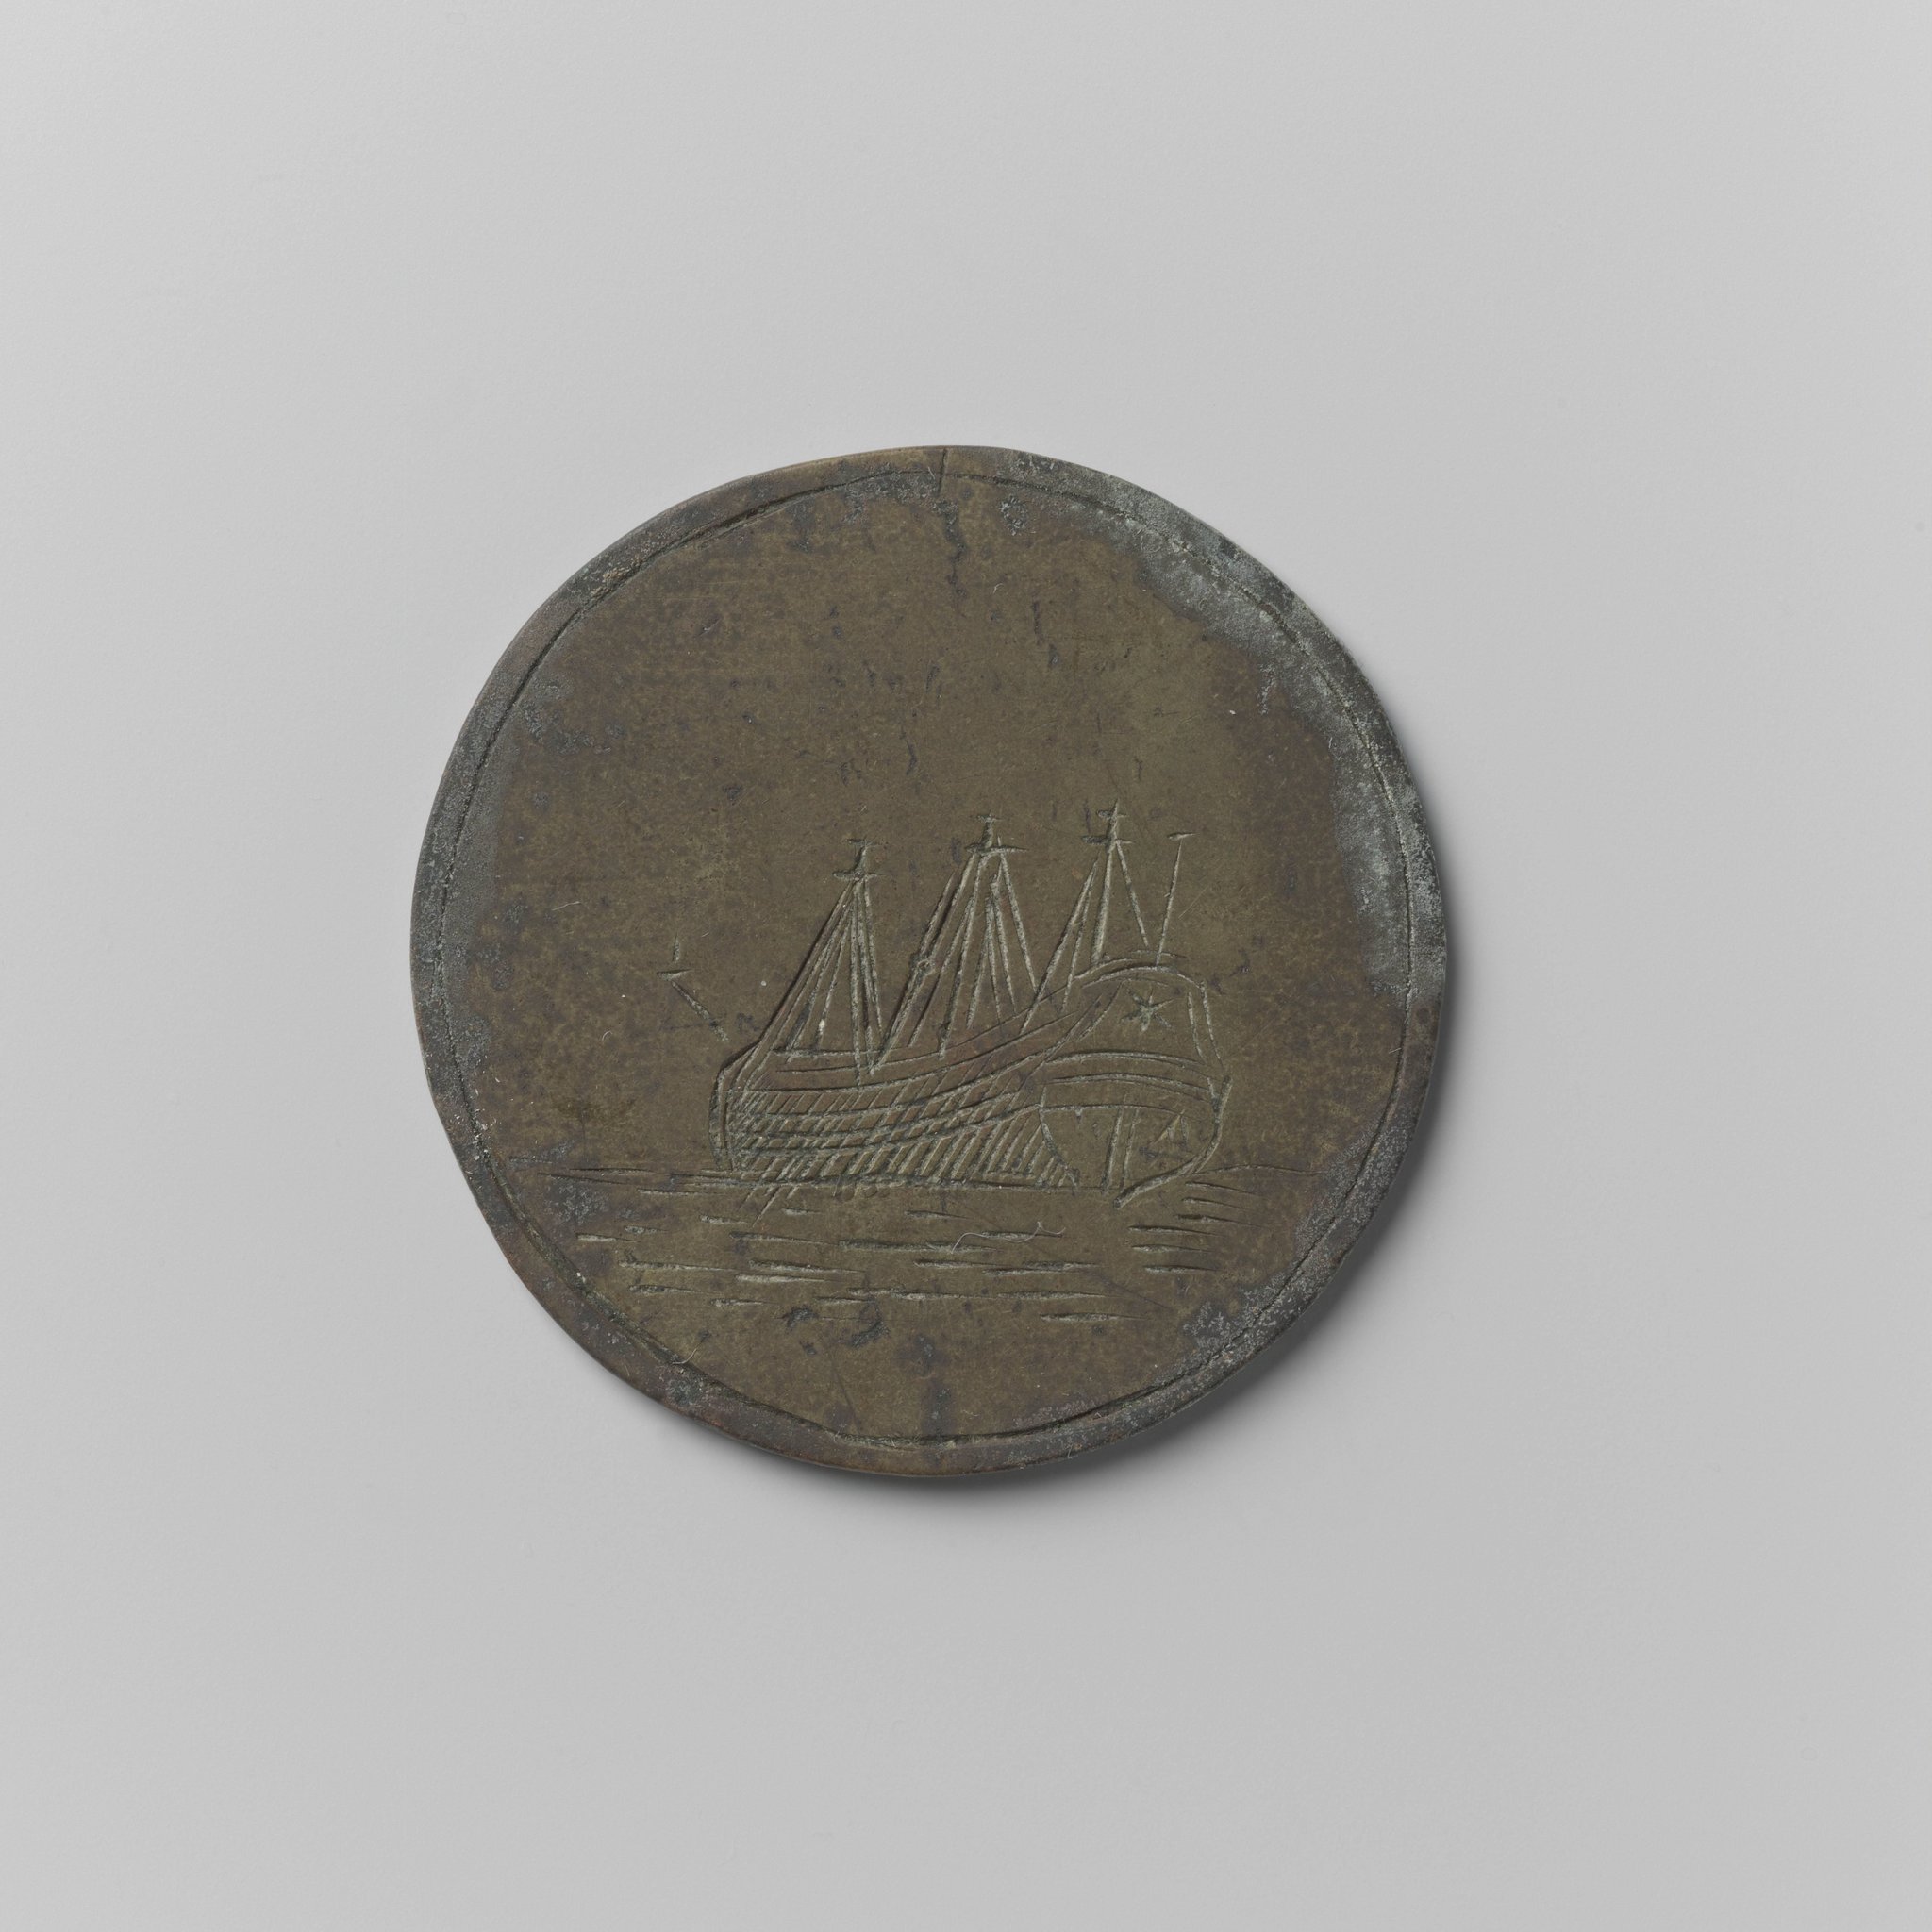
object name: medal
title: Scheepstimmerliedengilde van Amsterdam, gildepenning van Hendrick Basteiaenze de Voys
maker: Anonymous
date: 1700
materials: brass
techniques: engraving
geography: amsterdam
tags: amsterdam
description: Messing penning. Voorzijde: nog niet opgetuigde driemaster te water. Keerzijde: opschrift